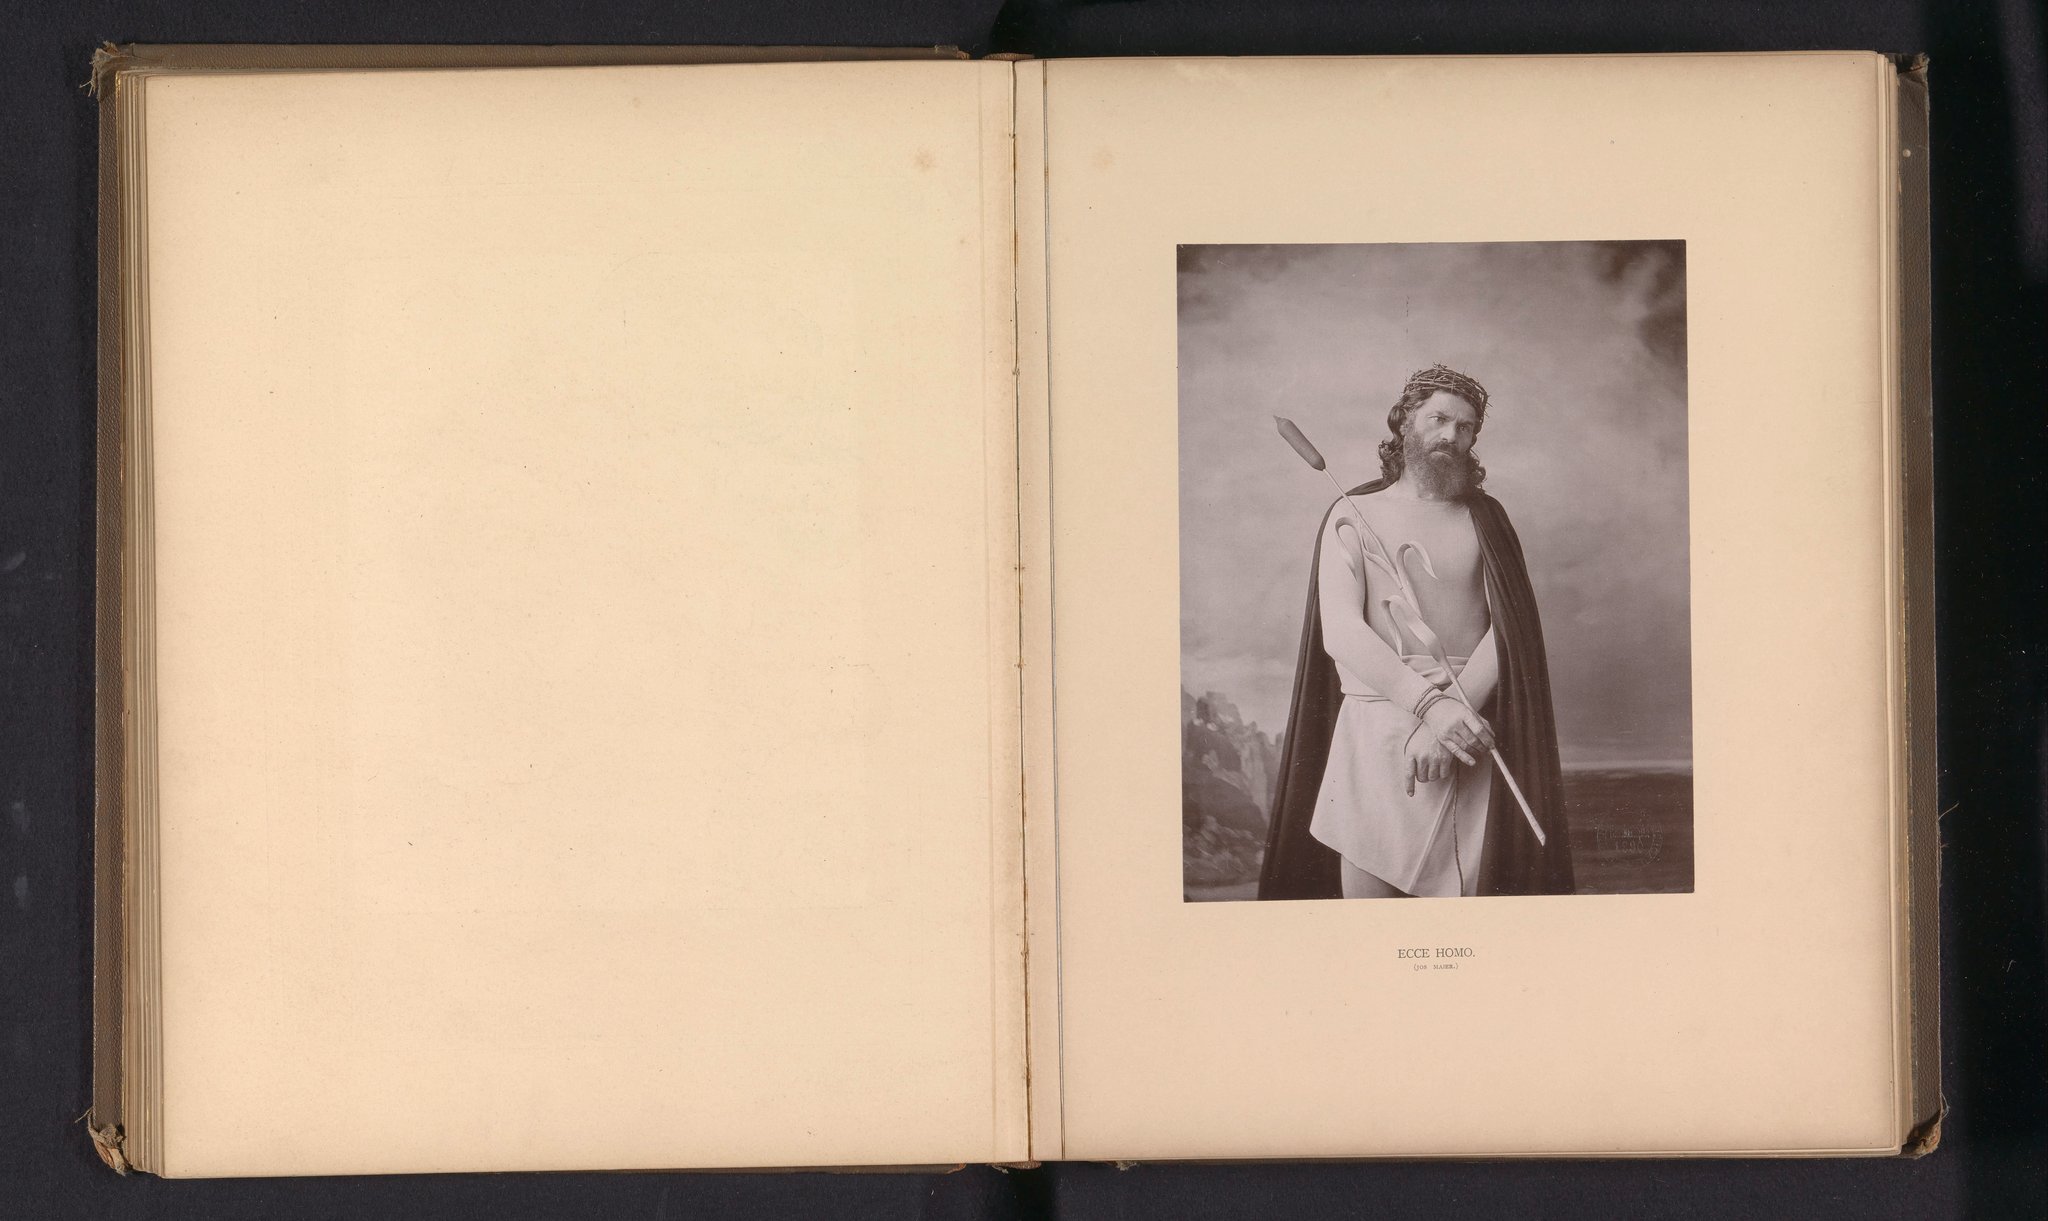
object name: photomechanical print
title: Ecce Homo (Jos Maier)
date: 1885-1890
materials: paper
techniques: photograph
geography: oberammergau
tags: christ alone (also called 'ecce homo'), portrait of actor, actress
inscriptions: inscription: ‘Gemeinde Oberammergau Passionsspiel 1890’